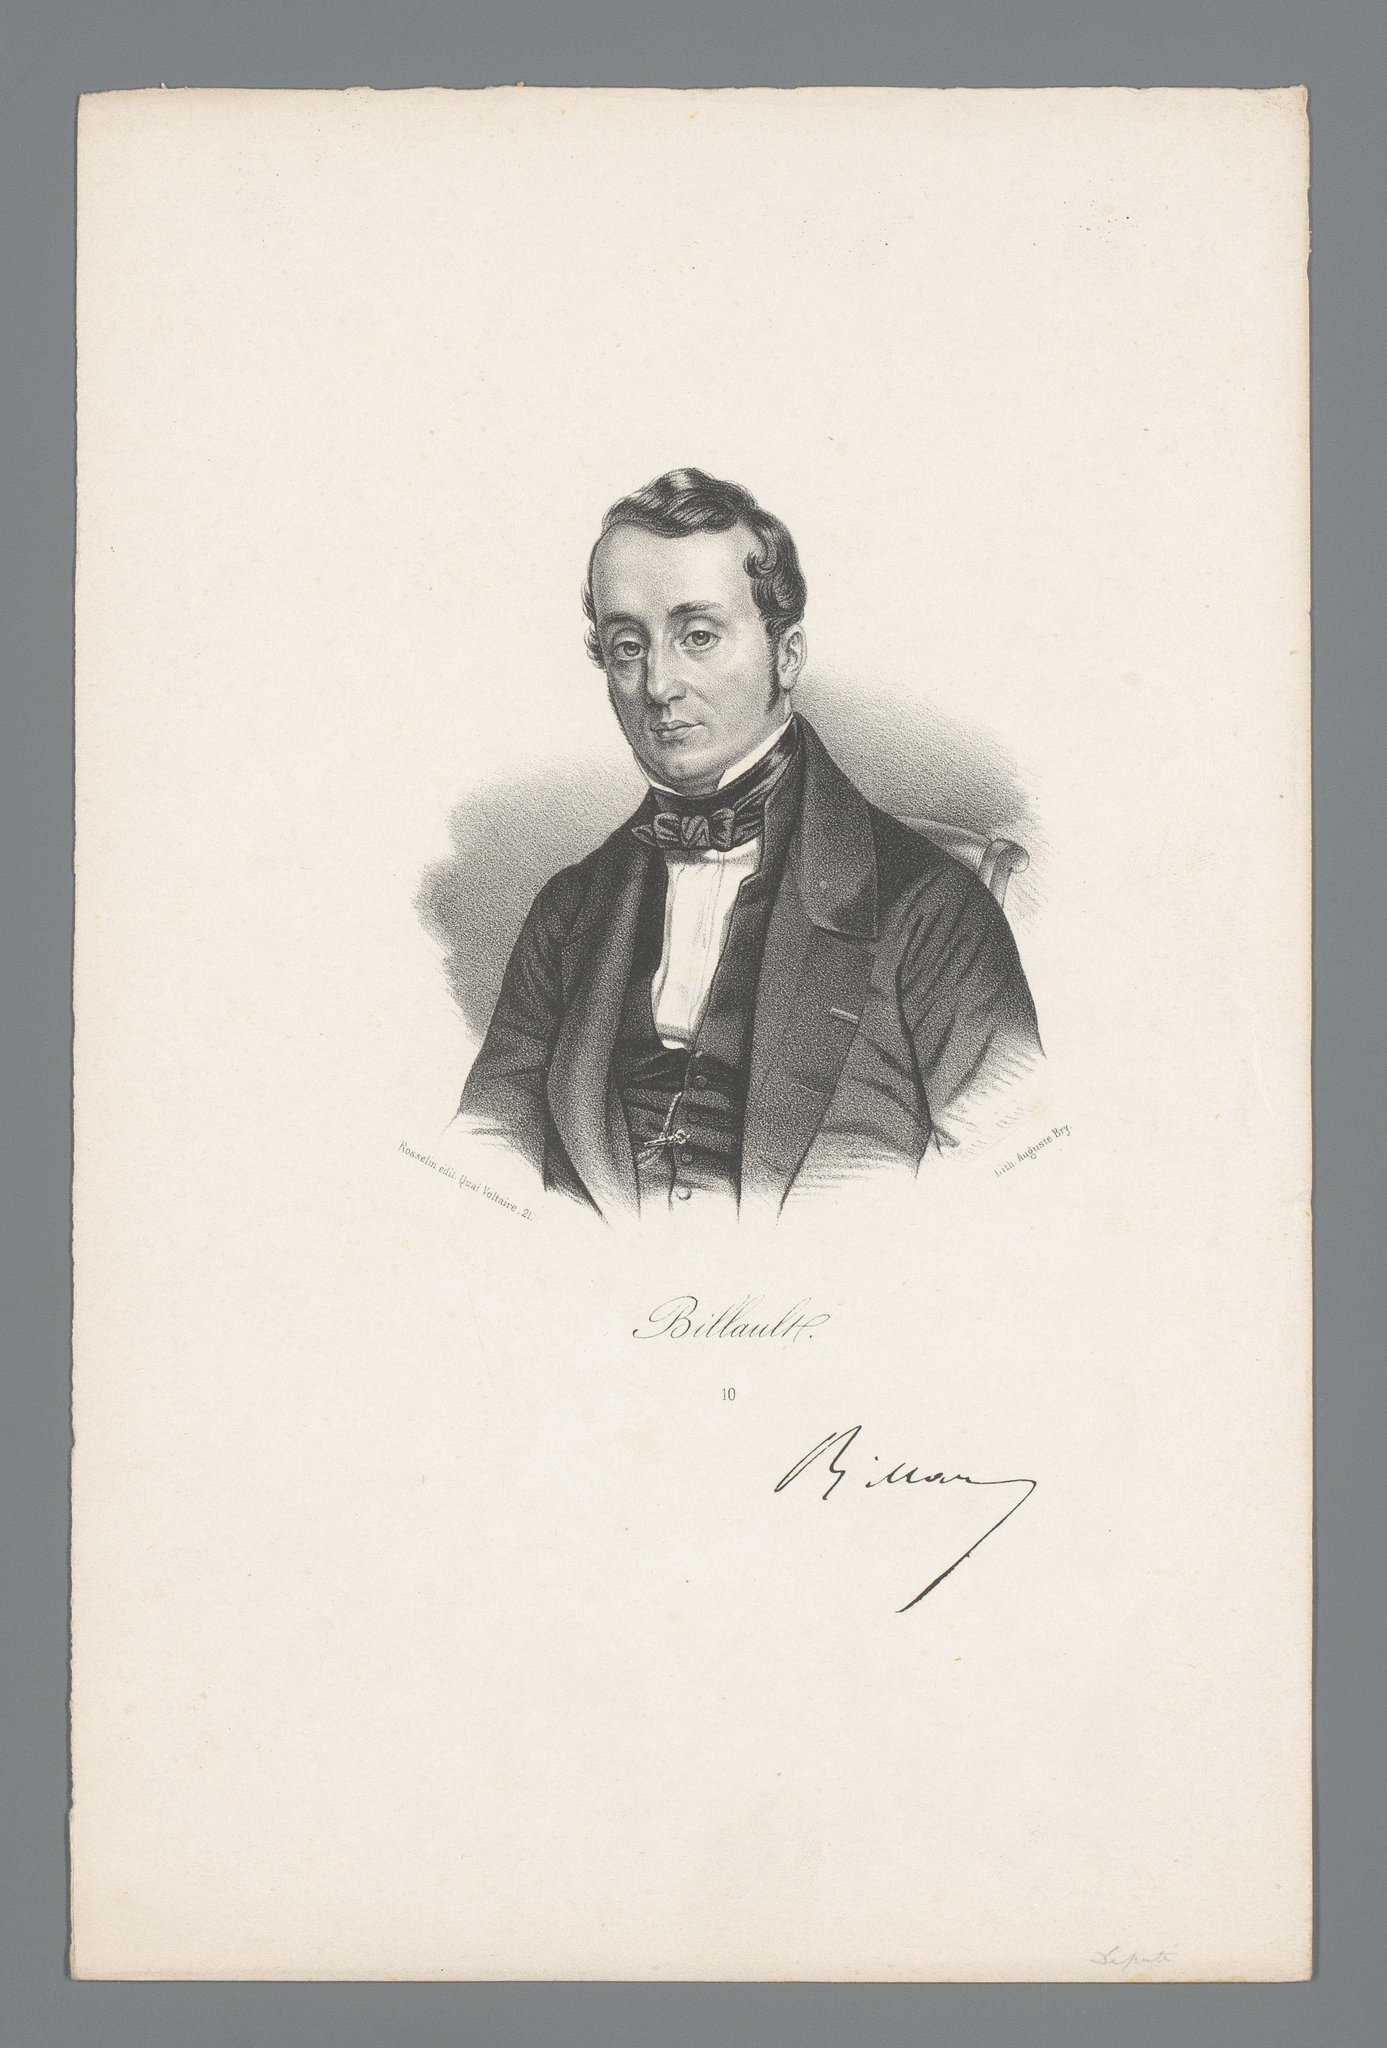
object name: print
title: Billault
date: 1848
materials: paper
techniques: lithograph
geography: paris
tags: historical persons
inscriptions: collector's mark: Lugt 2228